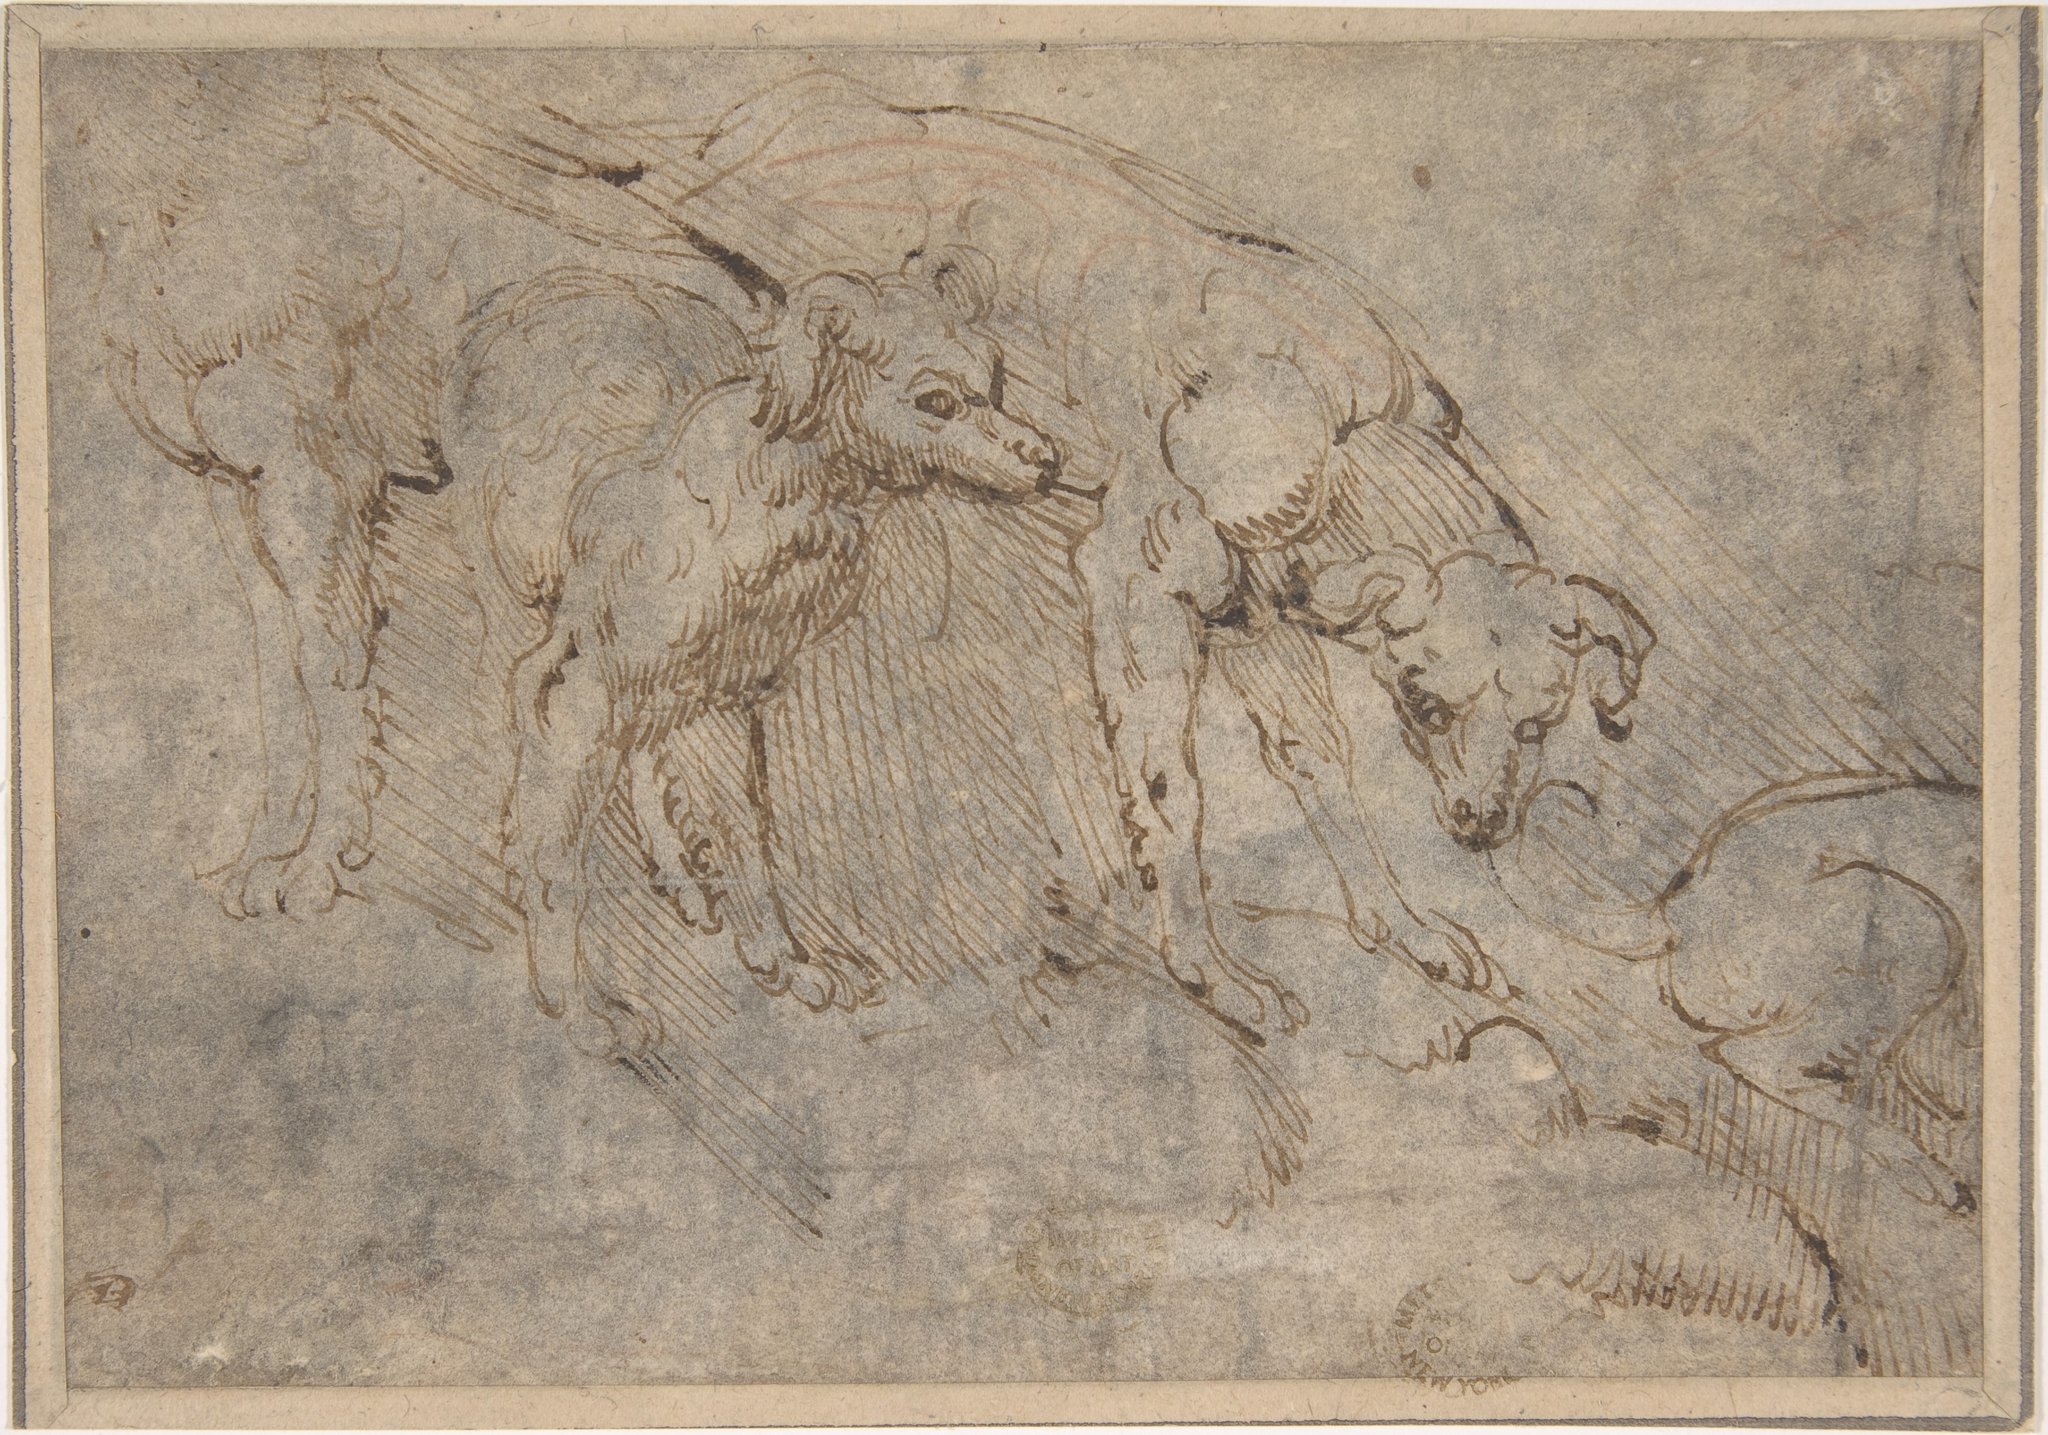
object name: drawing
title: Studies of a Dog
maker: anonymous, netherlandish, 16th century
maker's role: artist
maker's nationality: netherlandish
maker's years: 1500-1600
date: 1501-1600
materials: chalk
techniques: pen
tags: dogs